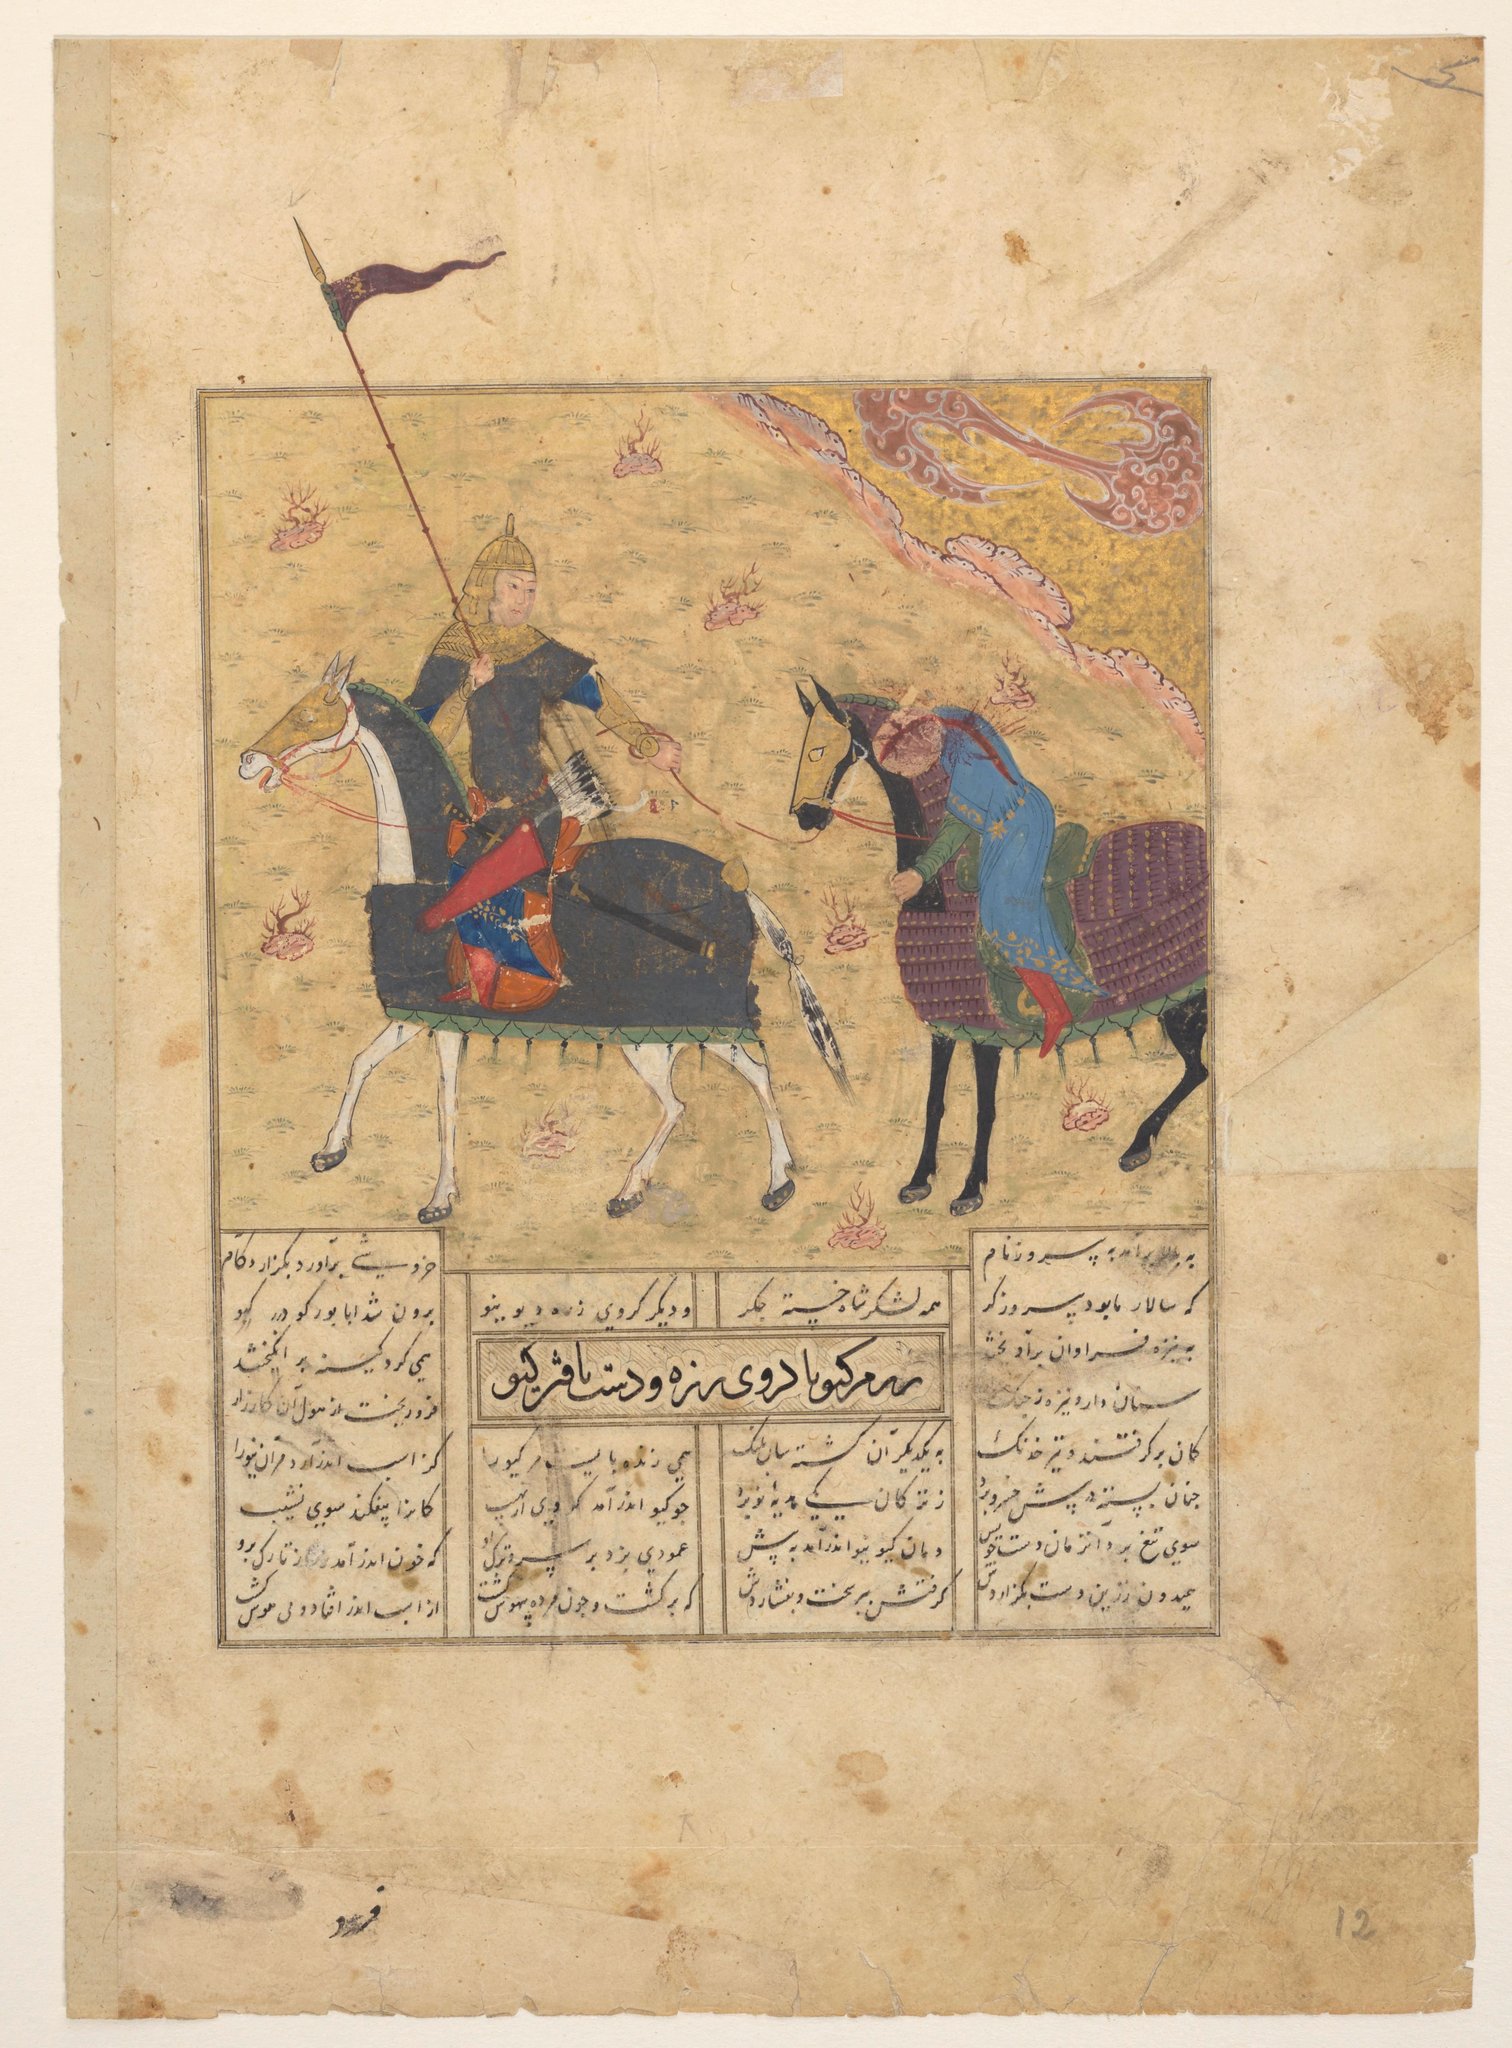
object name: persian miniature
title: Faribus doodt Kulbad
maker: Anonymous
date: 1500-1600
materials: paper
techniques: brush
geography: iran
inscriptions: inscription, inscription